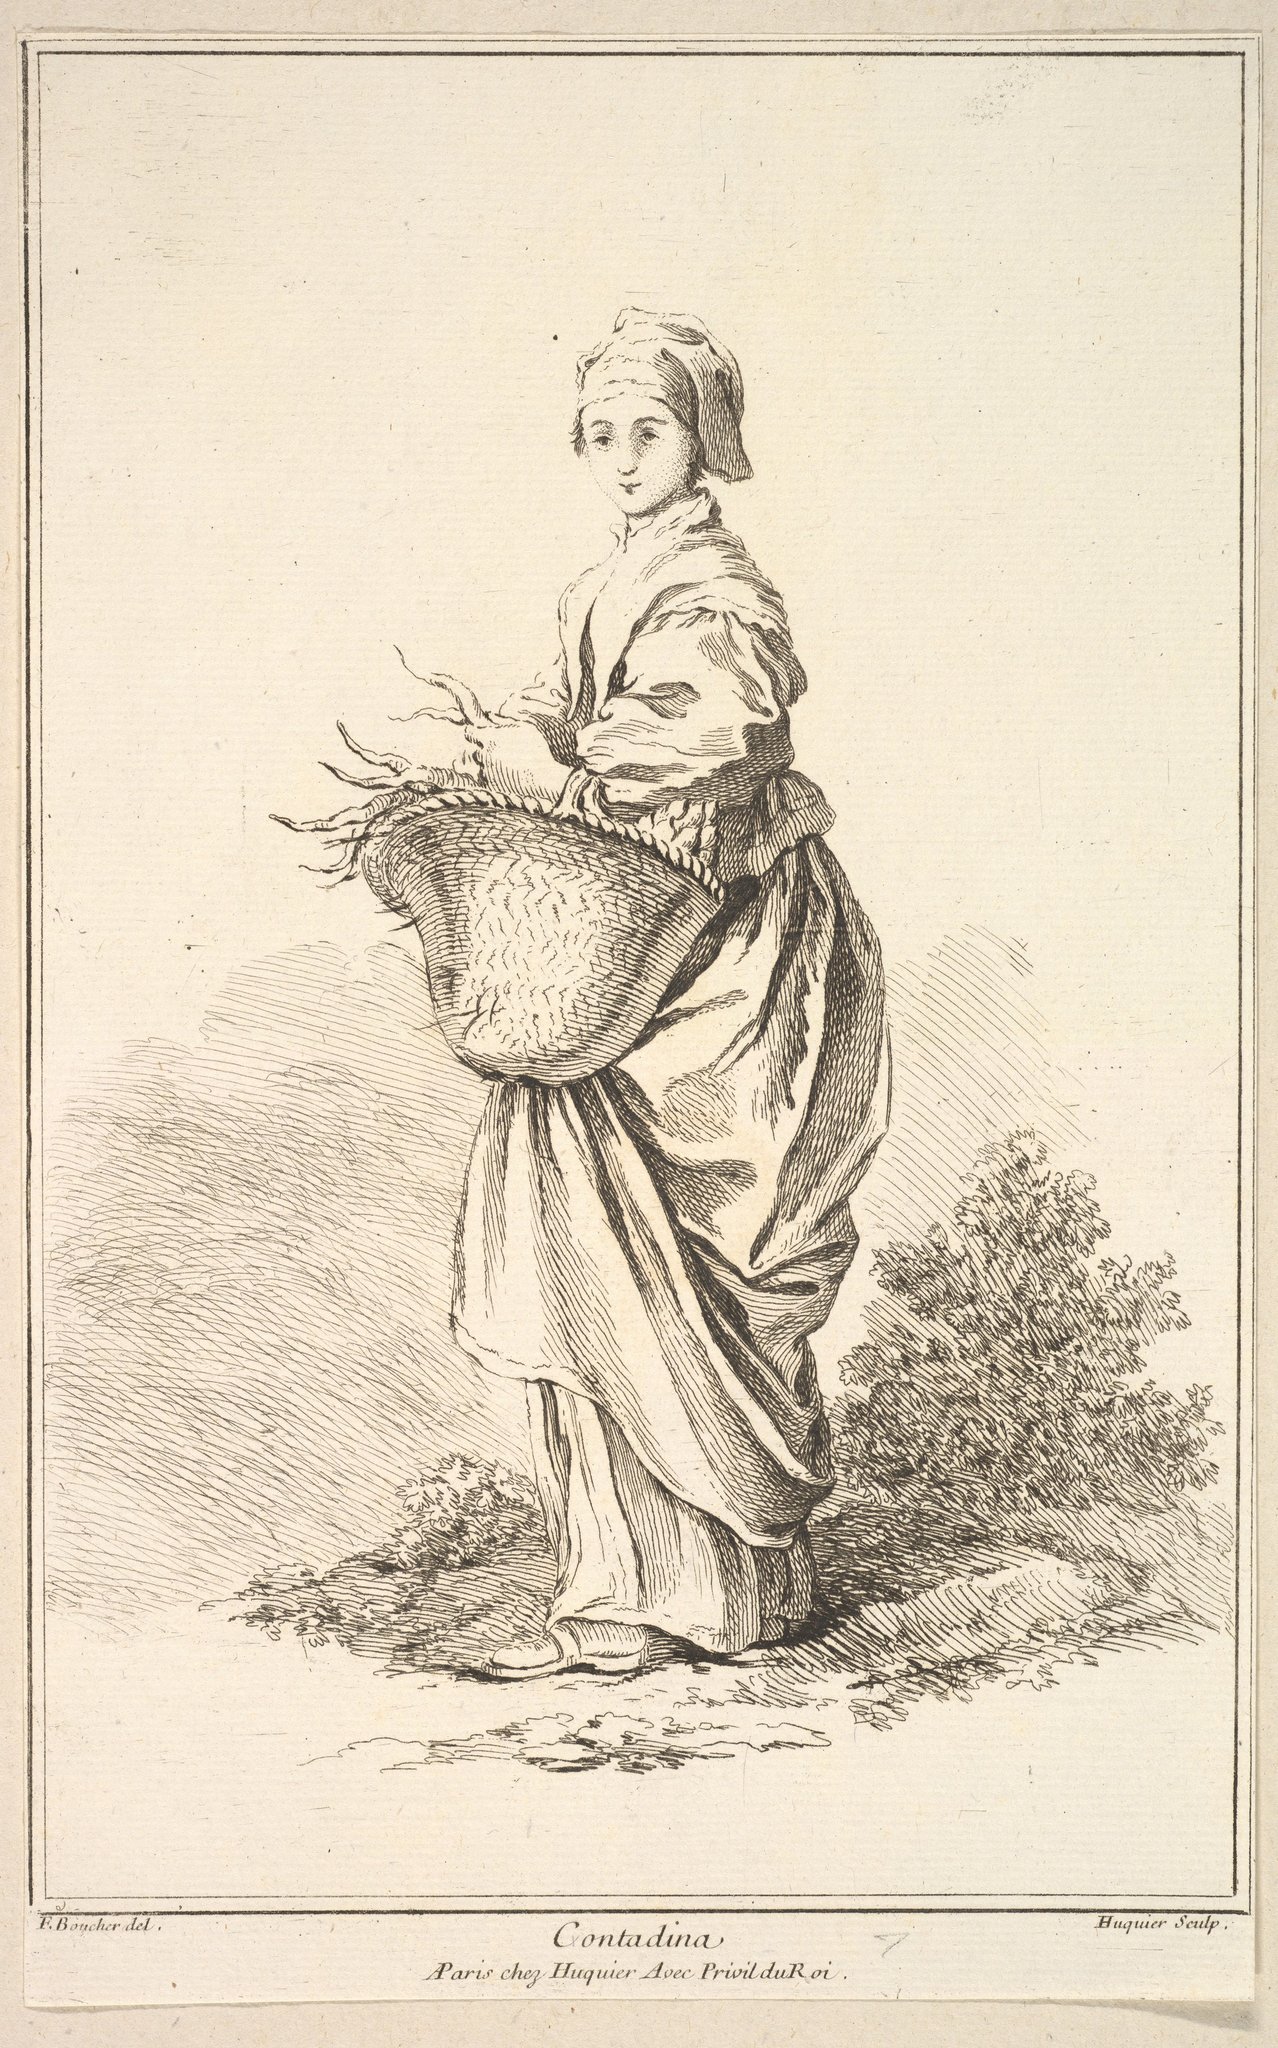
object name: print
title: Contadina, plate 11 from "Recueil de diverses fig.res étrangeres Inventées par F. Boucher P.tre du Roy et Gravées par F. Ravenet" (Collection of Various Foreign Figures, Devised by F. Boucher, Painter of the King and Engraved [etched] by F. Ravenet)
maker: gabriel huquier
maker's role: artist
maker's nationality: french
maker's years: 1695-1772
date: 1701-1800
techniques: engraving, etching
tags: women